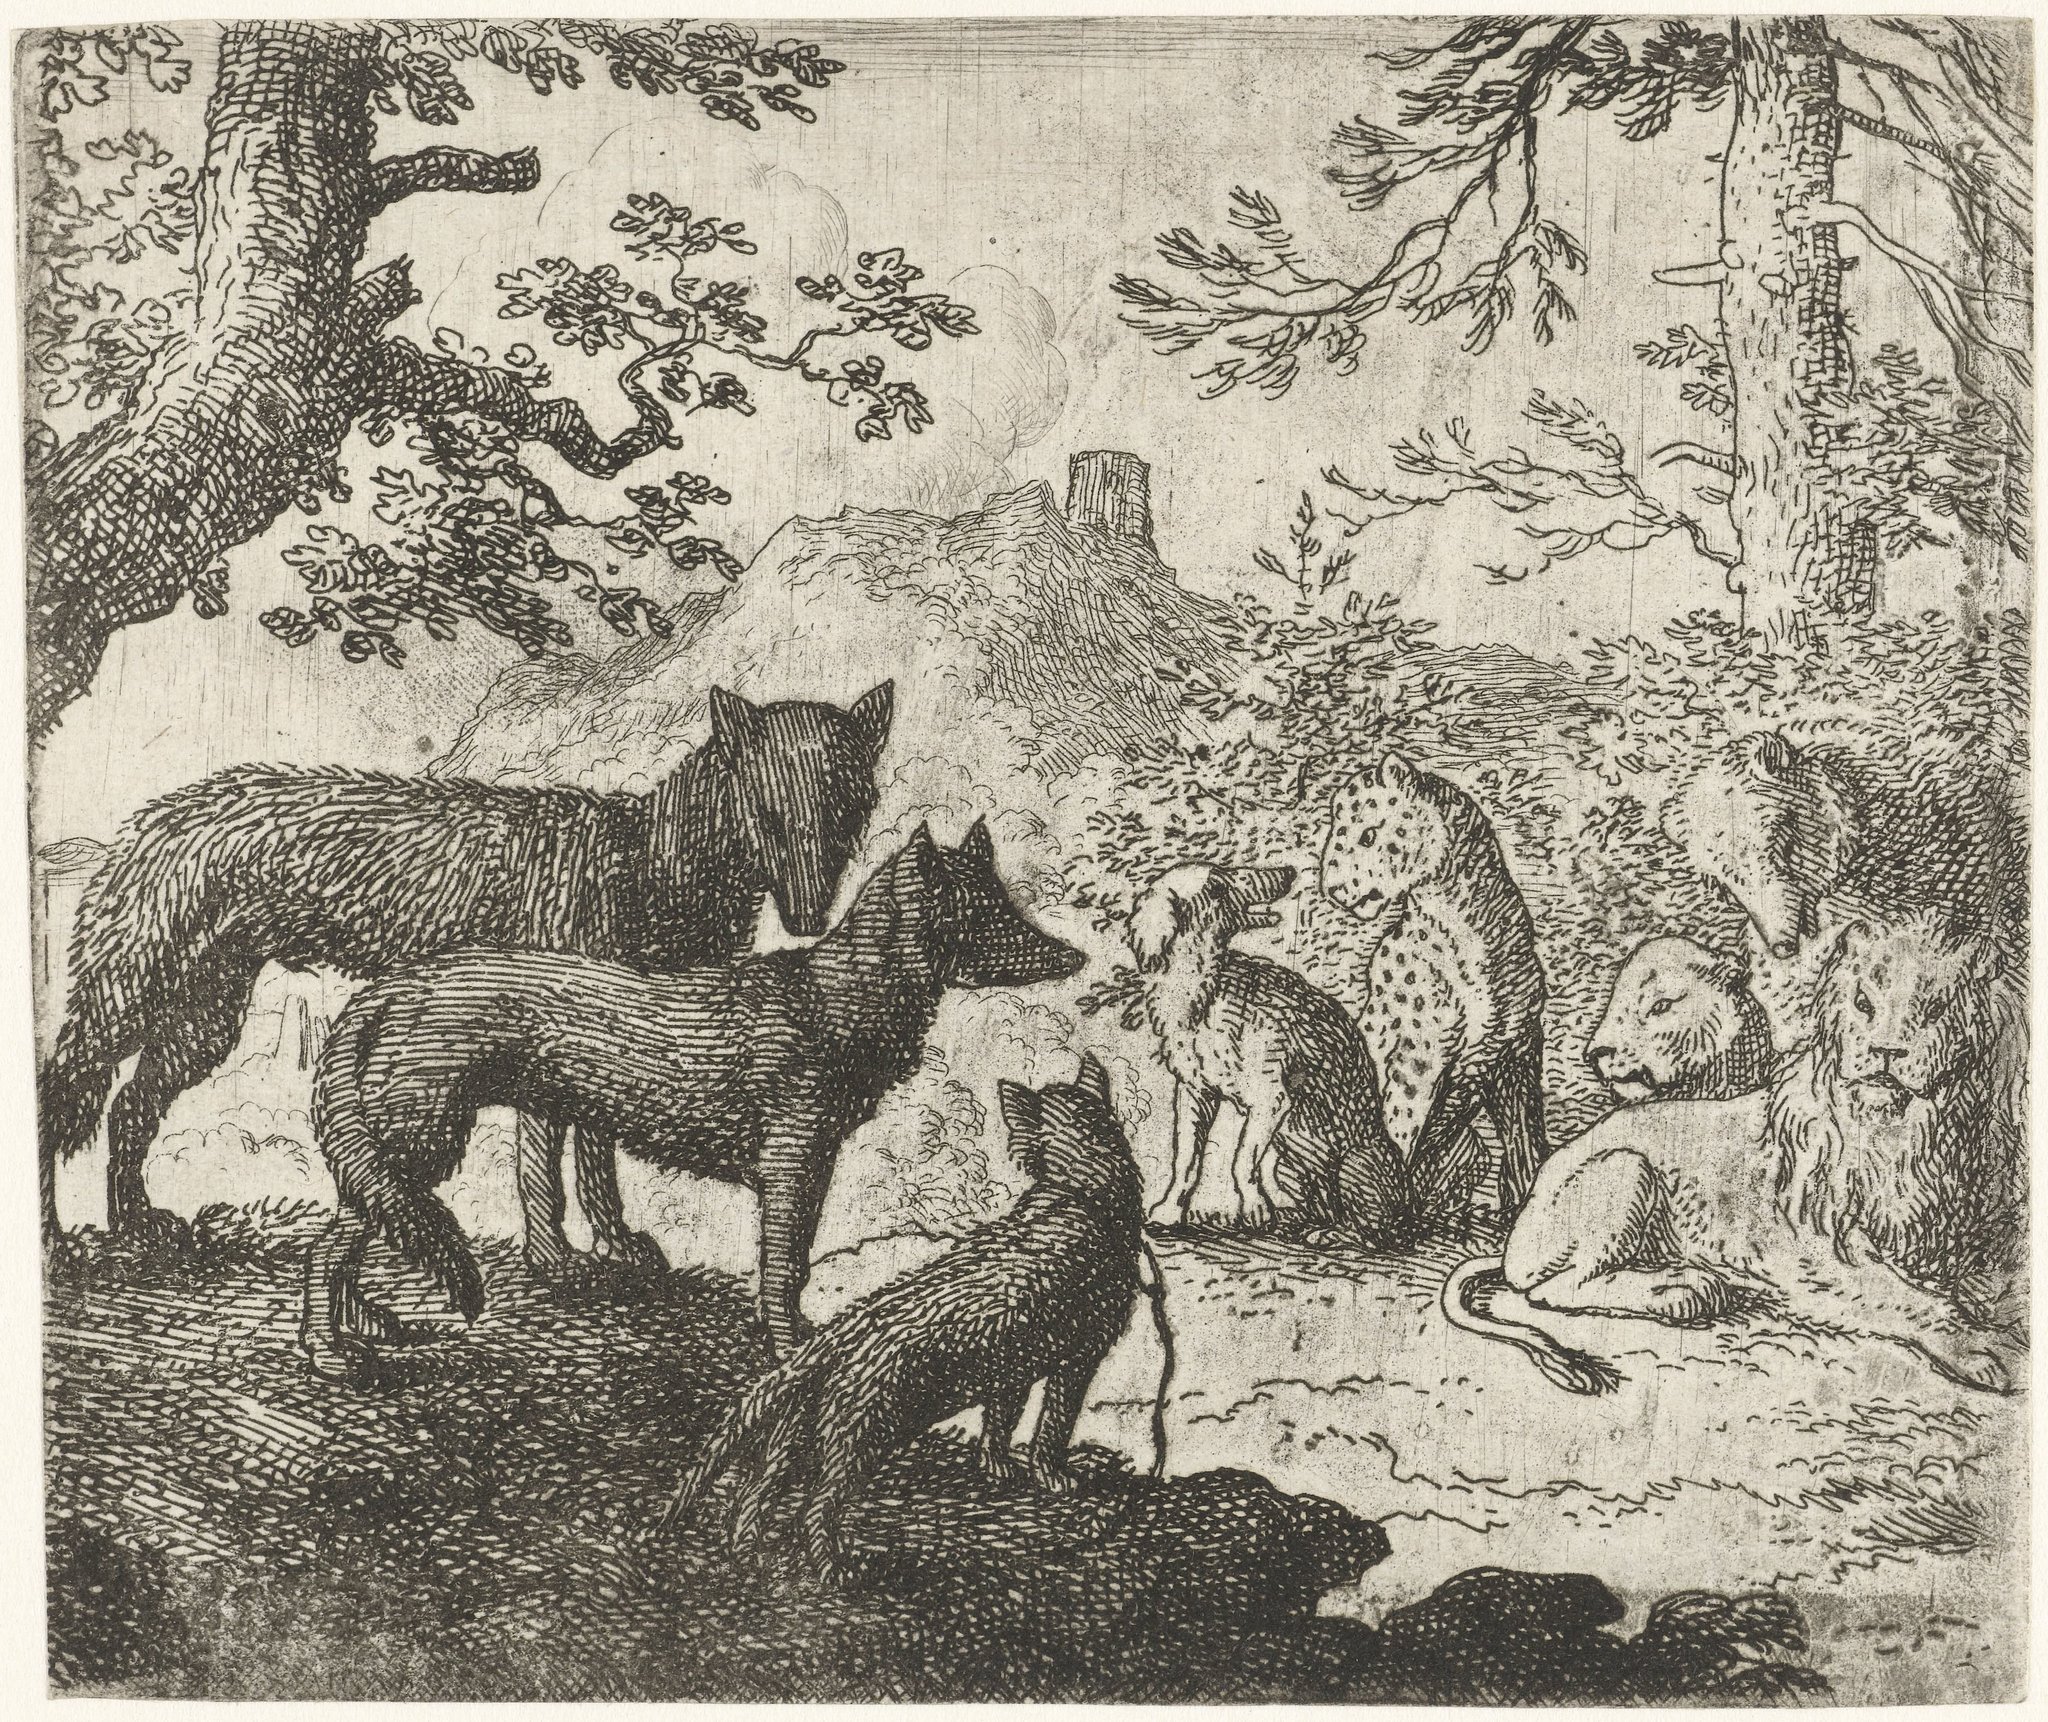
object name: print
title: Reinaert de vos' familie verlaat het gerecht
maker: allaert van everdingen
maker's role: draughtsman, painter, print maker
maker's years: 1621-1675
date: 1665-1675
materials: paper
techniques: etching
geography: netherlands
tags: fable of reynard the fox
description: De leeuw, koning Nobel, kijkt in het bijzijn van vier andere dieren, naar de drie vossen in de schaduw op de voorgrond.